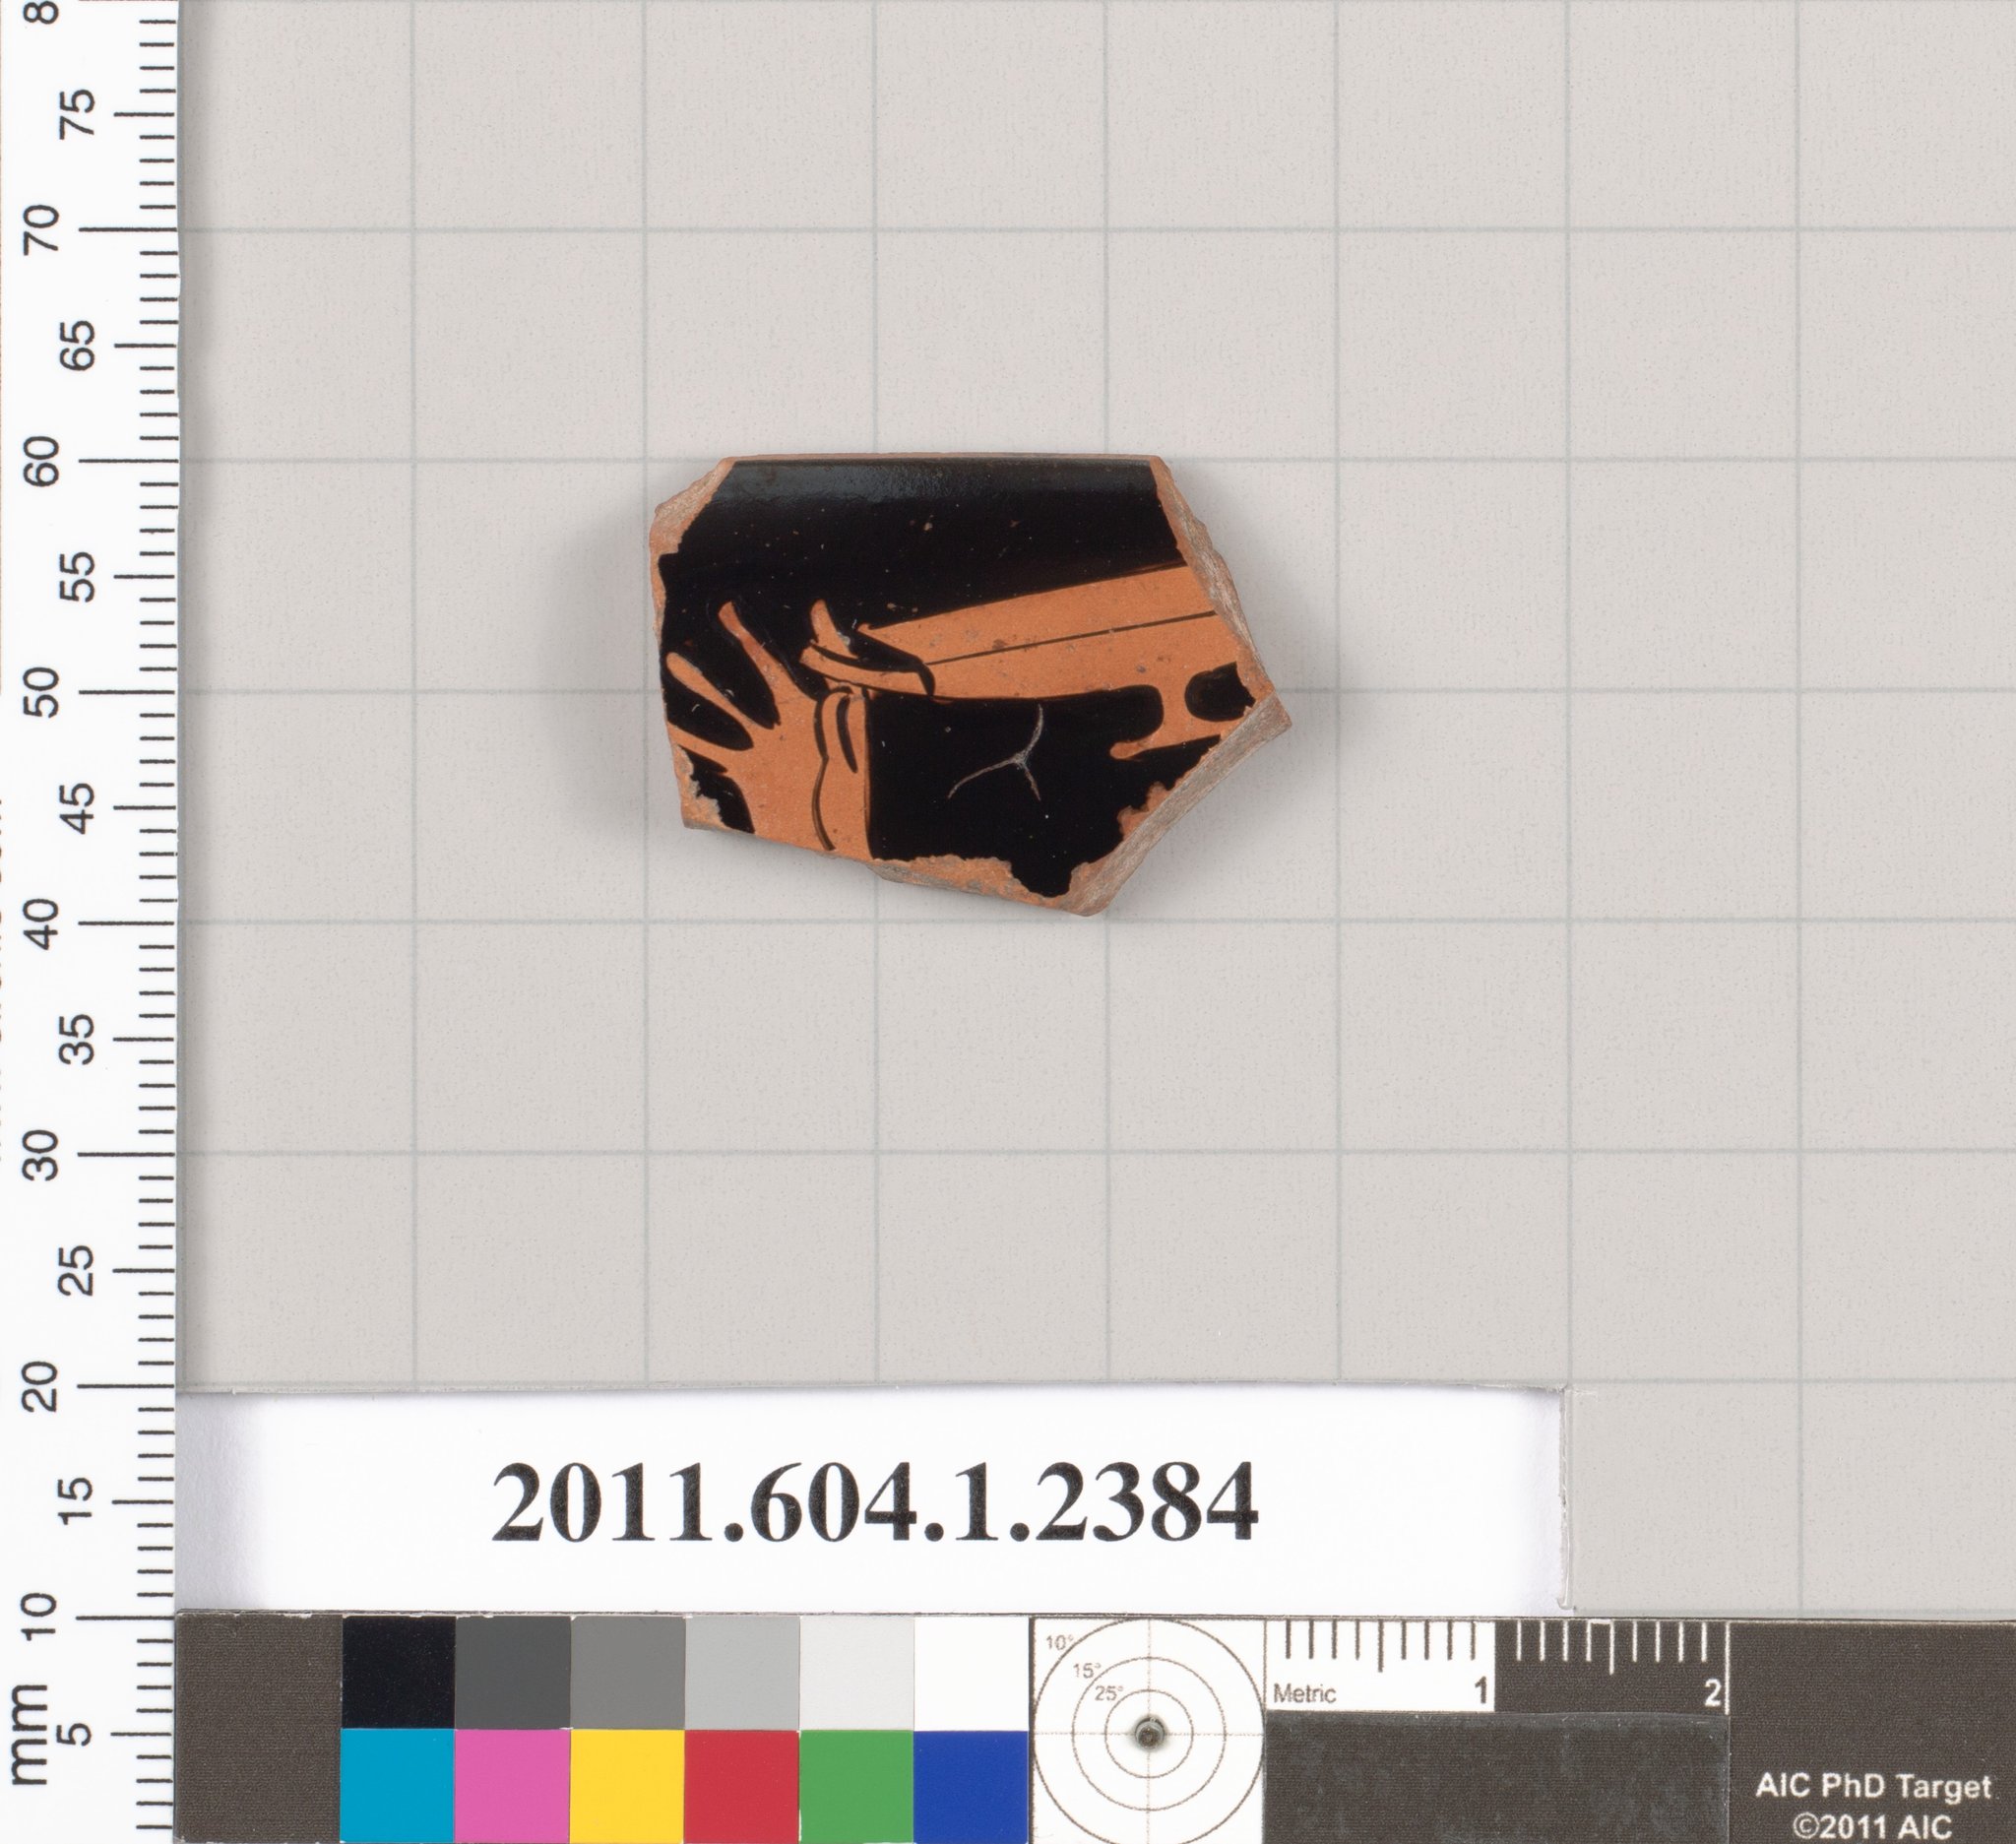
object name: kylix fragment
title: Terracotta rim fragment of a kylix (drinking cup)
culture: greek, attic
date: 490-480 BCE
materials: terracotta